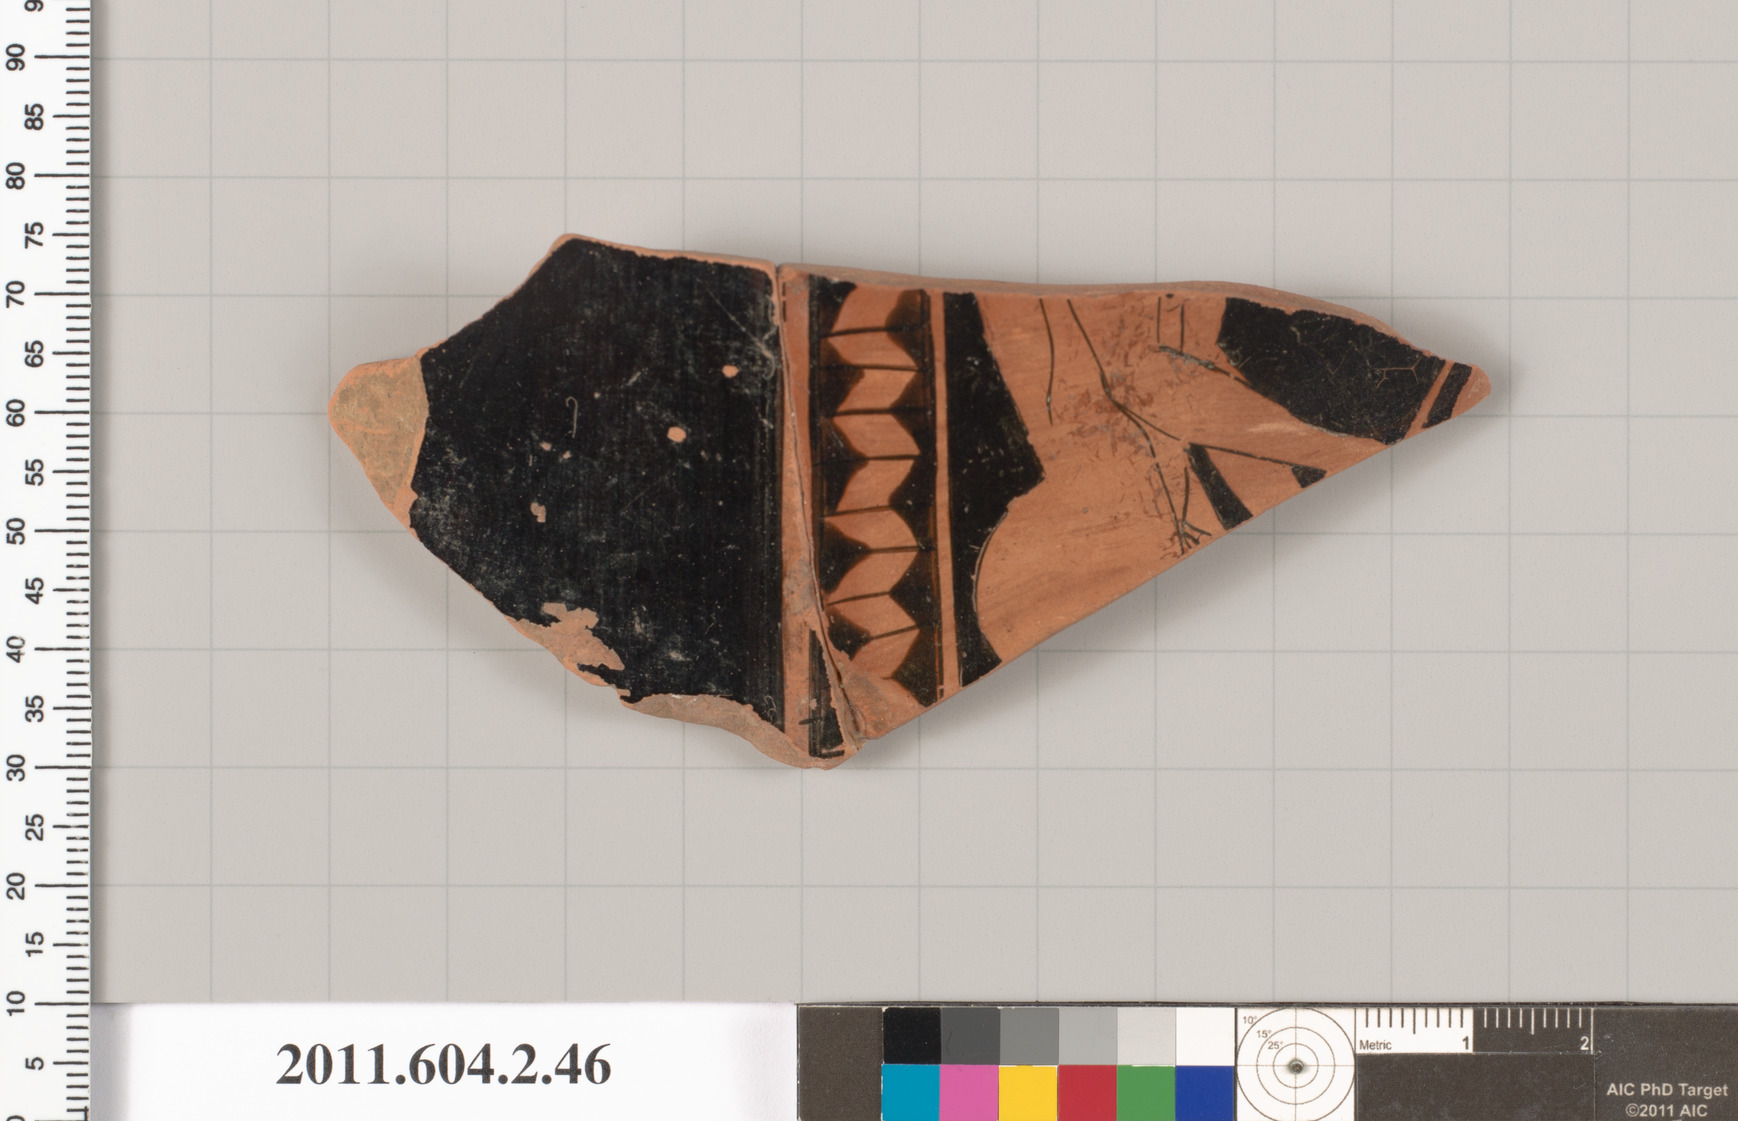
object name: pelike fragment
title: Terracotta fragment of a pelike (jar)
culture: greek, attic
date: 510-490 BCE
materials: terracotta